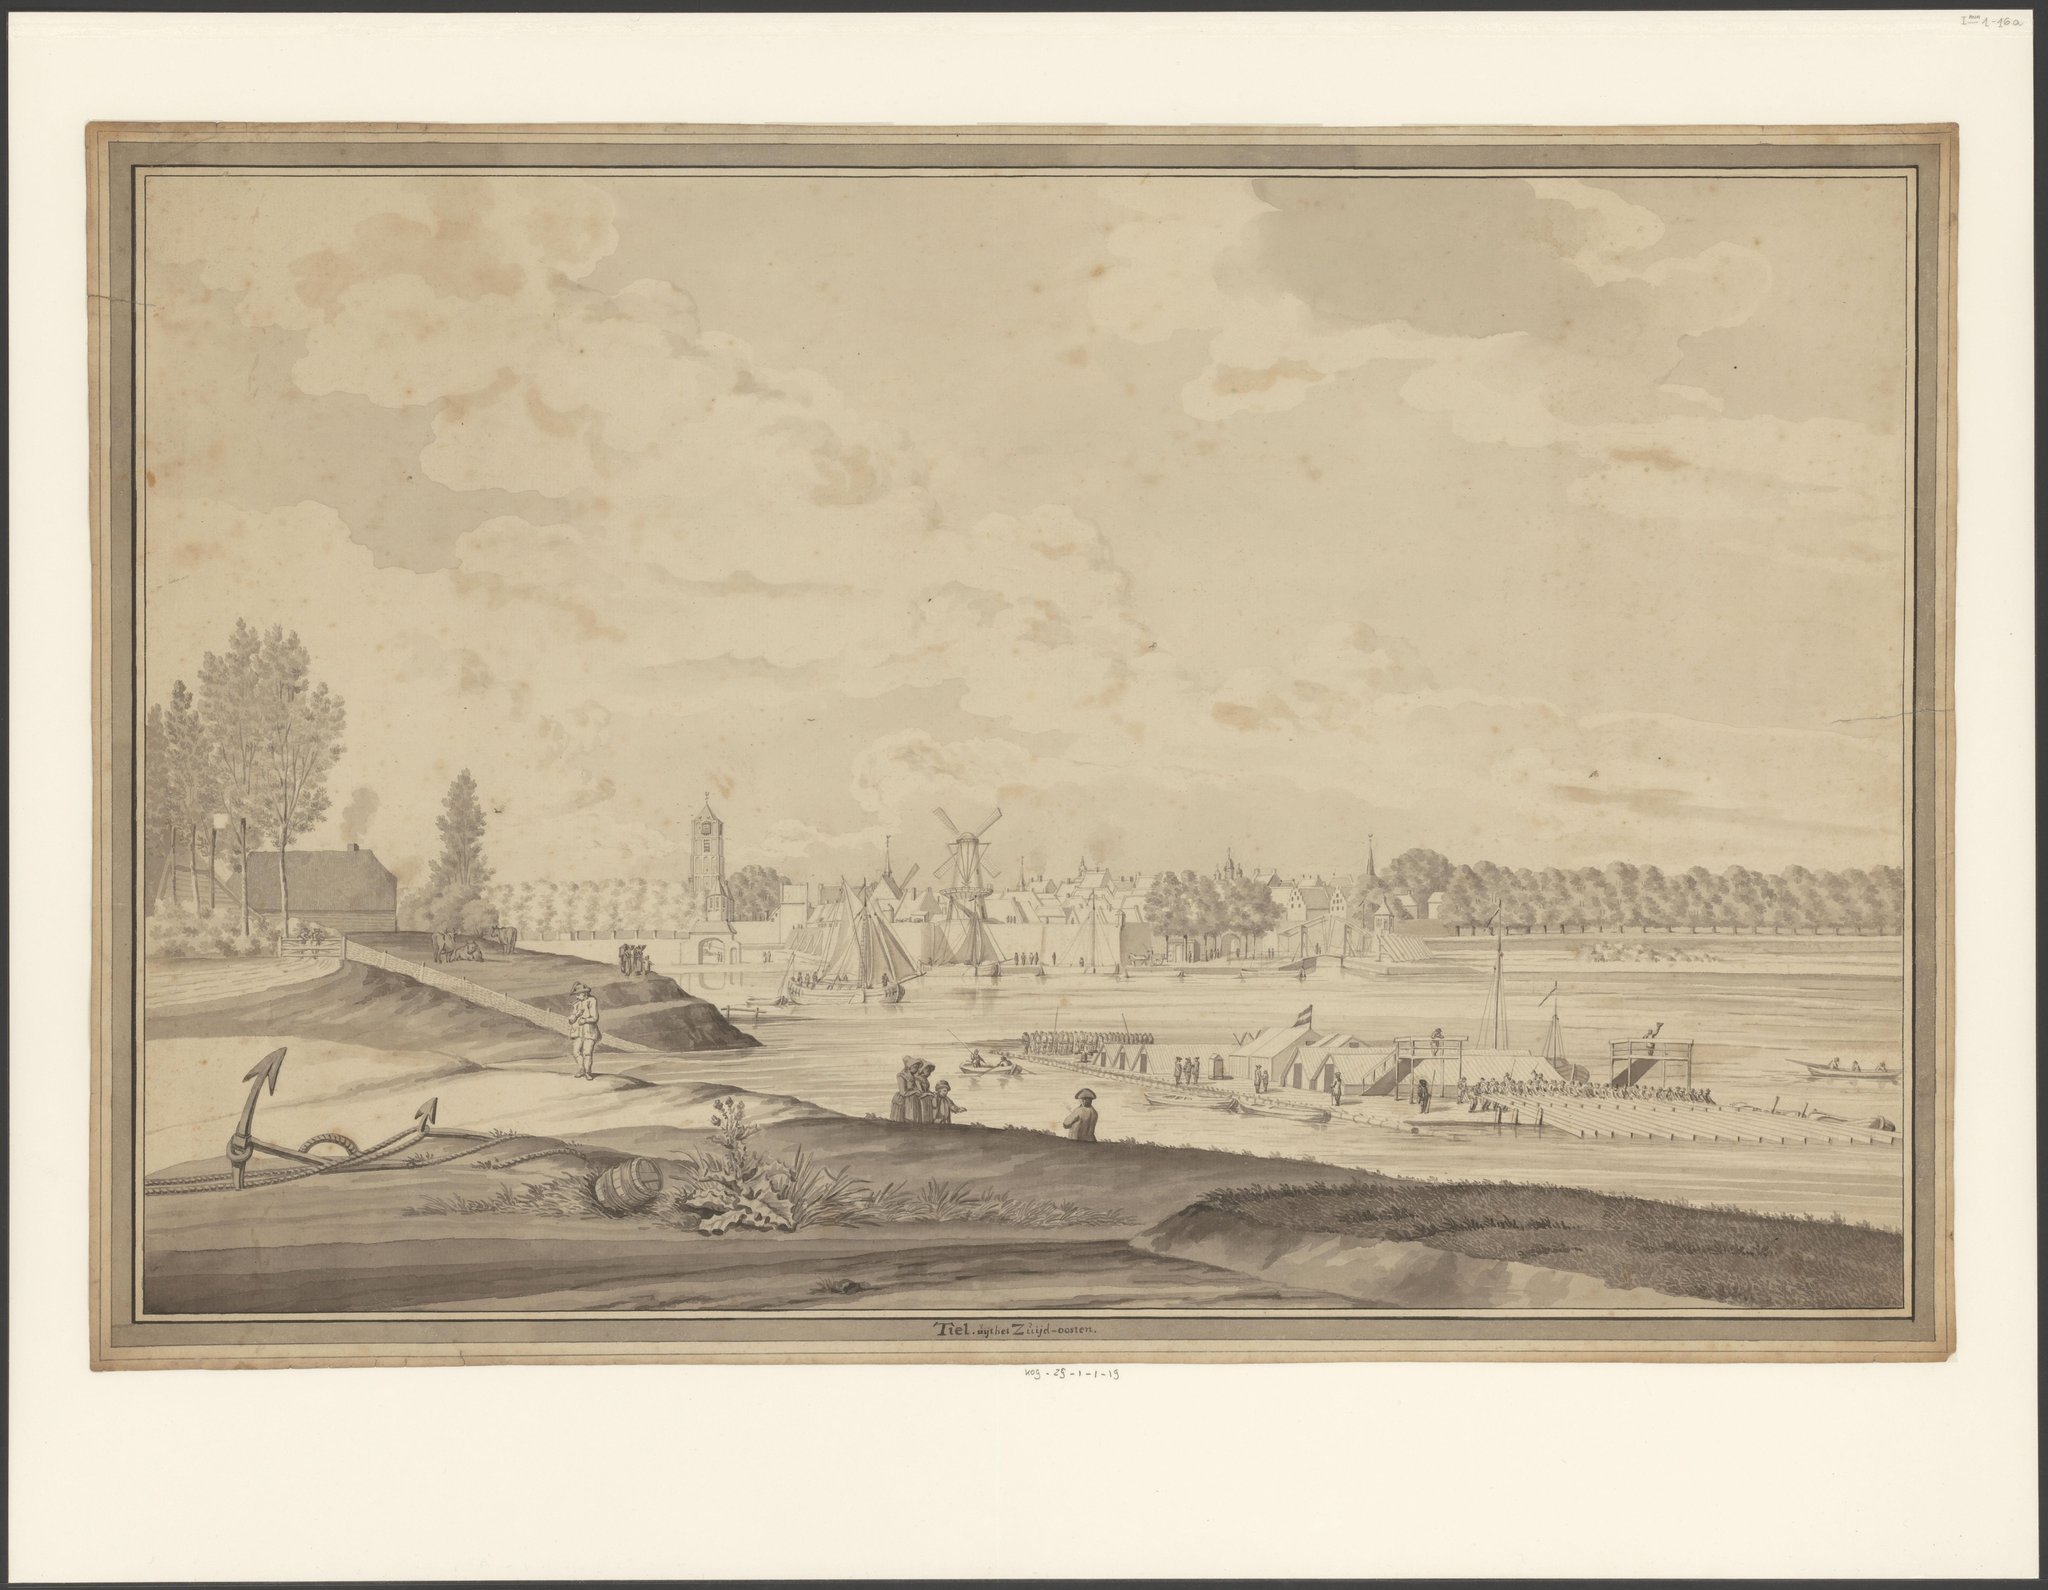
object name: drawing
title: Gezicht op Tiel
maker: Anonymous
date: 1750-1799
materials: ink, paper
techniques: brush, pen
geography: netherlands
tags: raft, prospect of city, town panorama, silhouette of city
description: Gezicht op de stad Tiel, gezien van de overkant van de Waal. Op het water een groot houten vlot met enkele barakken of tenten, uitkijksteigers, een vlag en aan twee zijden groepen roeiers. Op de voorgrond een steiger met een man met een wagen. Onderwerpsrubrieken binnen de Atlas Zeden en Gewoonten: topografie; stadsprofielen.